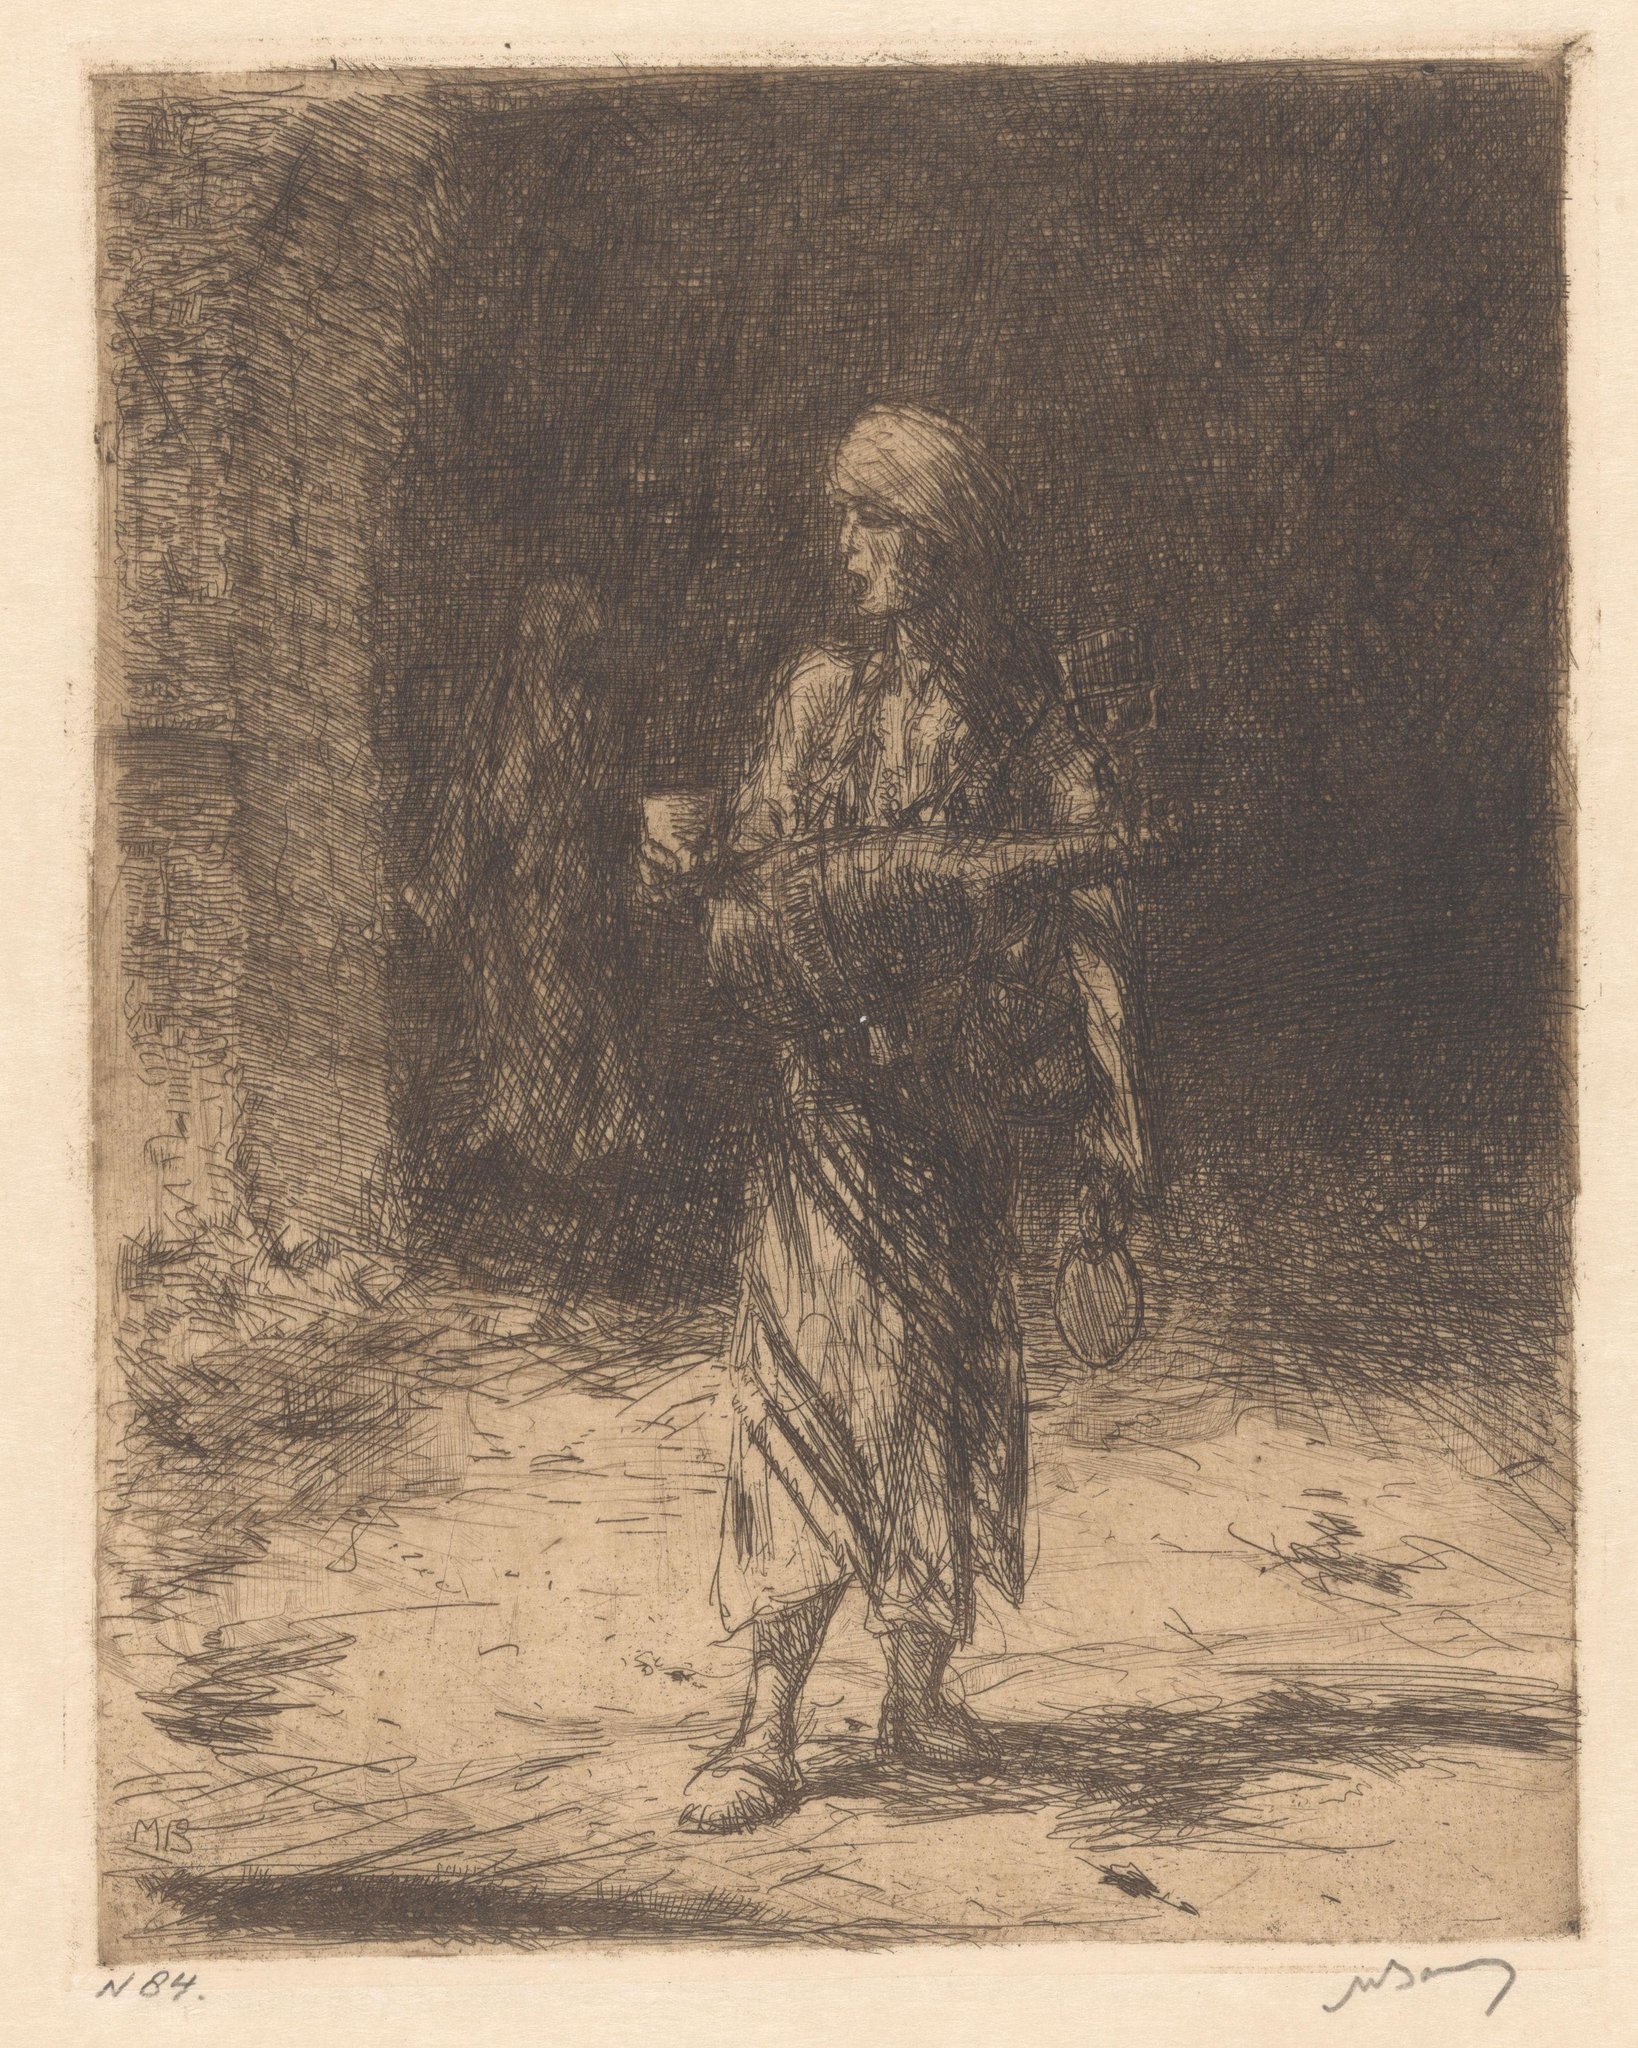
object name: print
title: Egyptische waterdrager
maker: marius bauer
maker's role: draughtsman, print maker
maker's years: 1867-1932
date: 1922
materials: paper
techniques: etching, intaglio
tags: wandering or travelling merchant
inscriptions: collector's mark: Lugt 2228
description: Een man draagt een kruik met water op zijn borst.